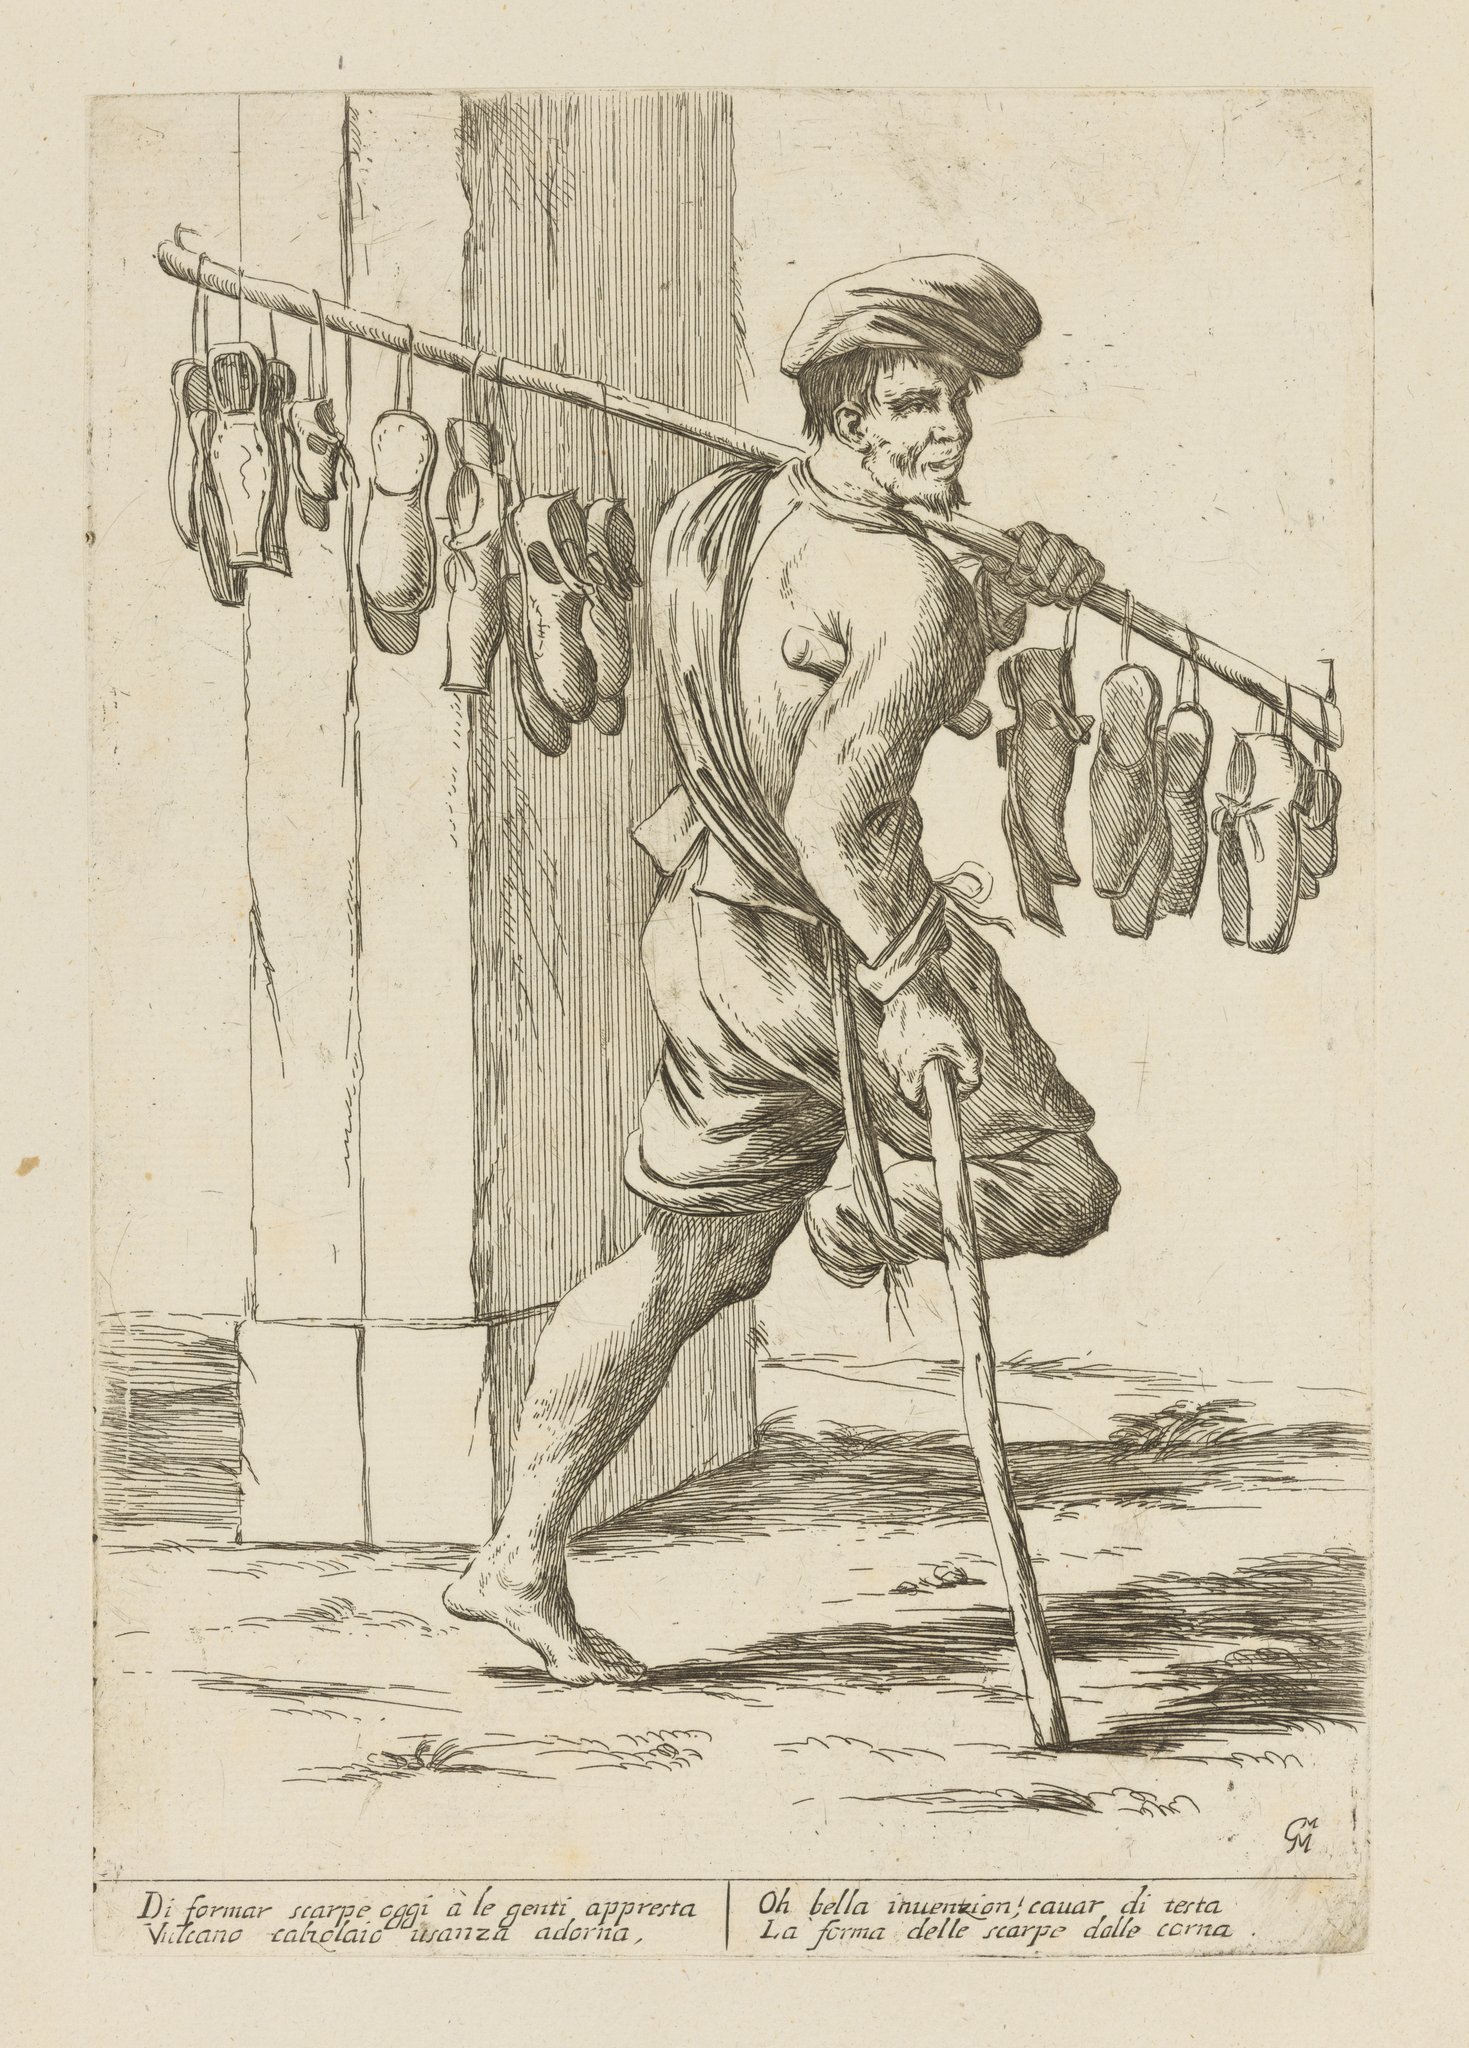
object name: print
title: Vendor of Shoes, from Di Bologna l'Arti per via D'An.ibal' Ca.rac, plate 15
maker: giuseppe maria mitelli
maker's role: artist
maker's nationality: italian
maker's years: 1634-1718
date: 1660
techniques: etching